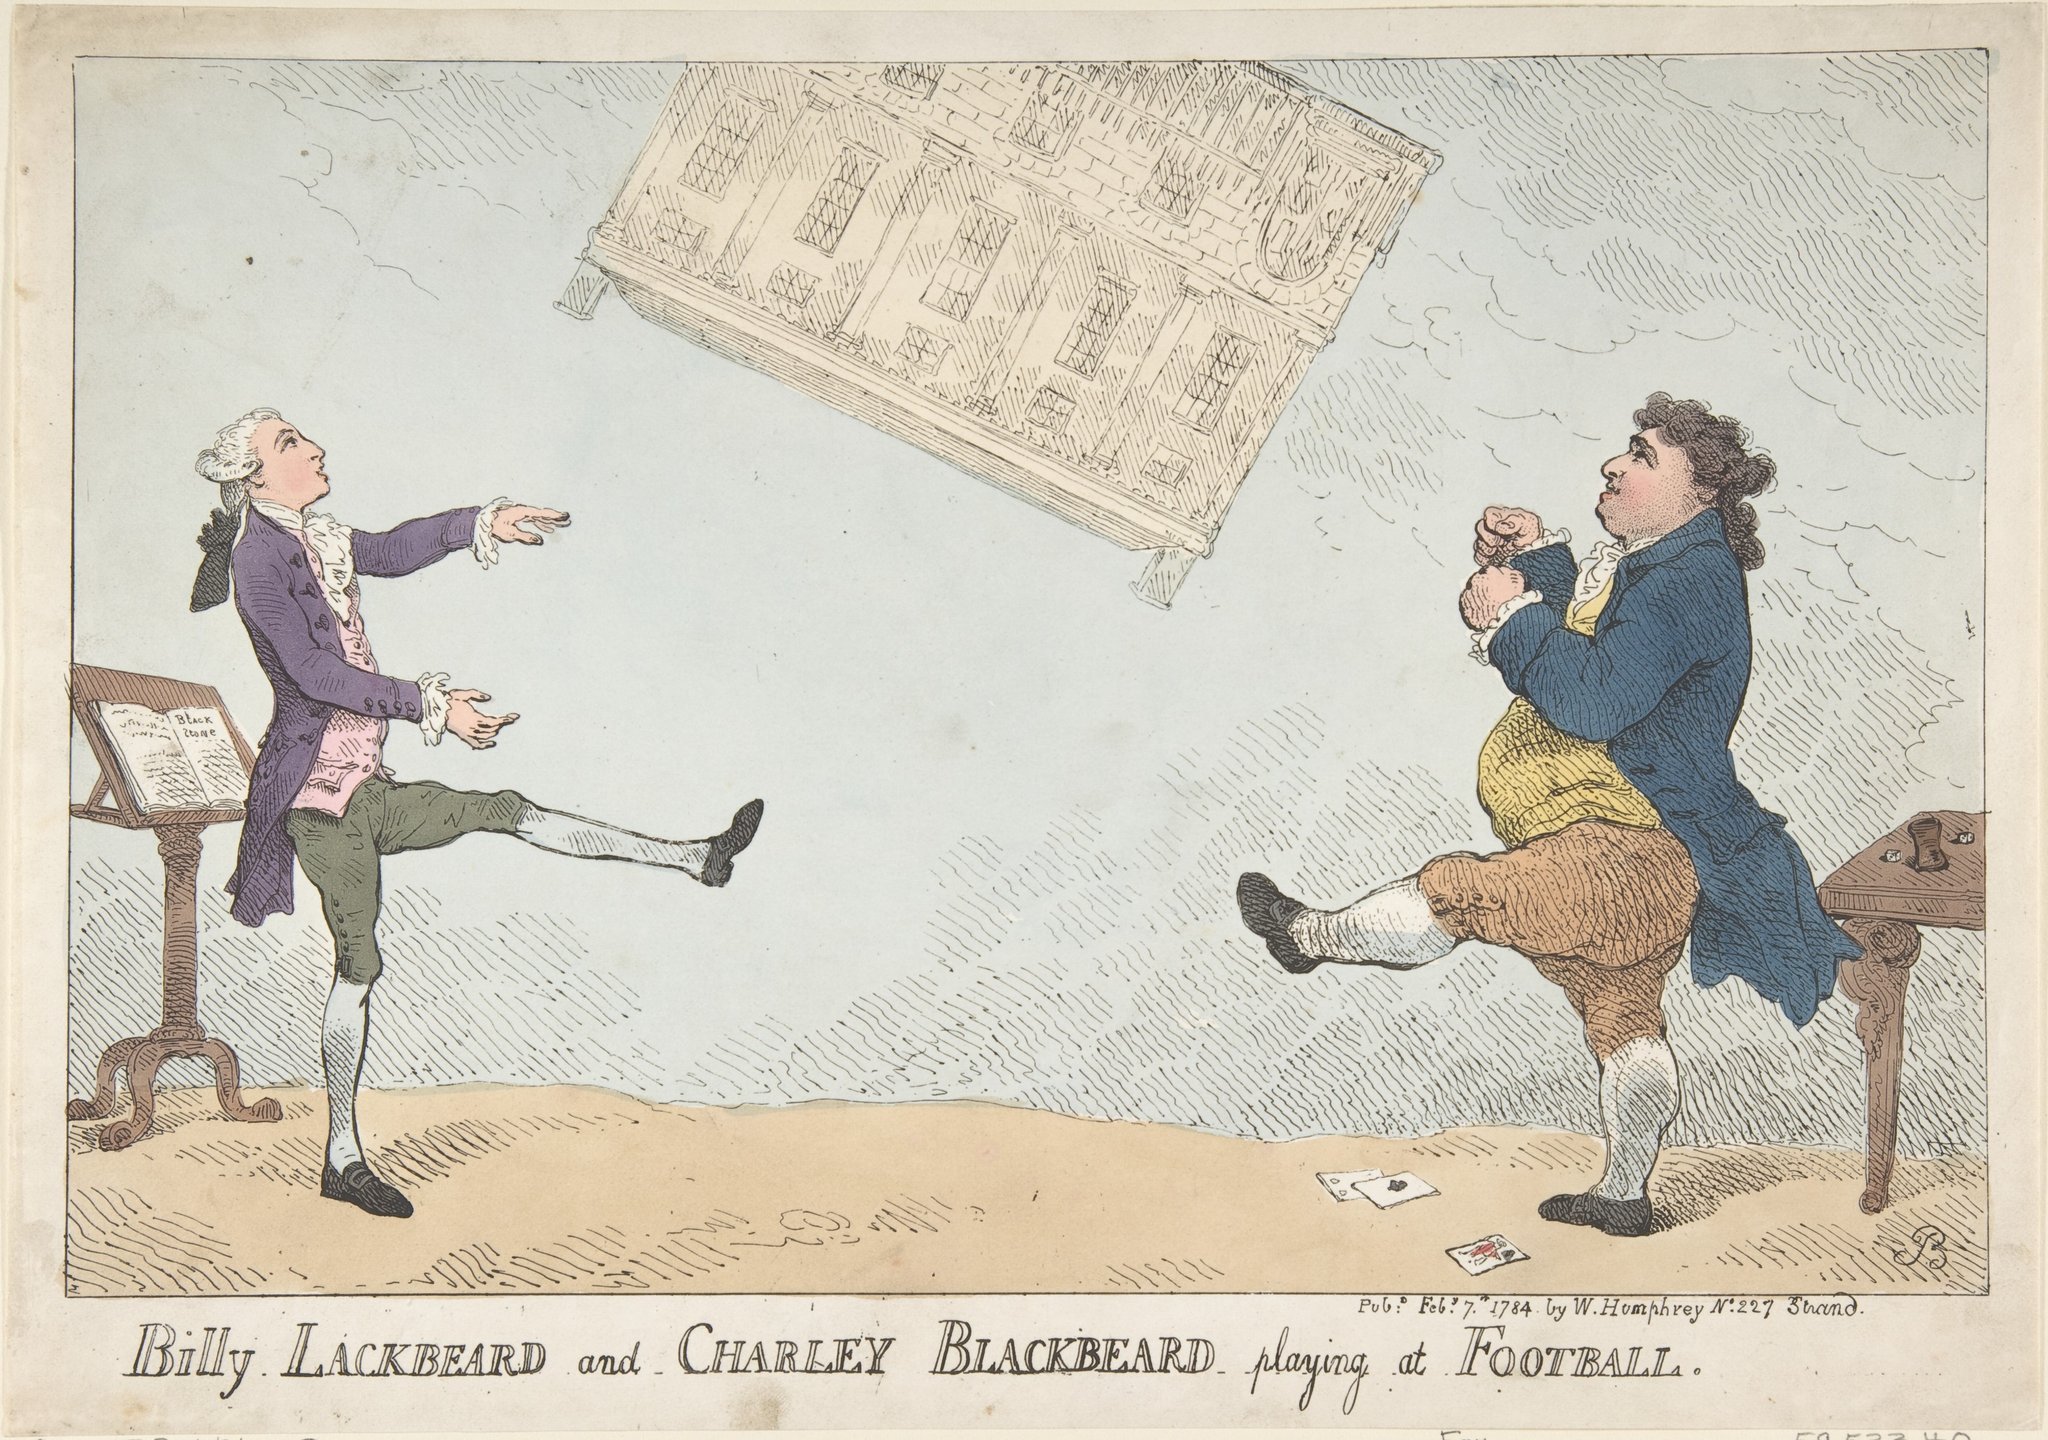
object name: print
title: Billy Lackbeard and Charley Blackbeard playing at Football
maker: thomas rowlandson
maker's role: artist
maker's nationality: british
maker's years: 1757-1827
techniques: etching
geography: london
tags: satire,men,politics